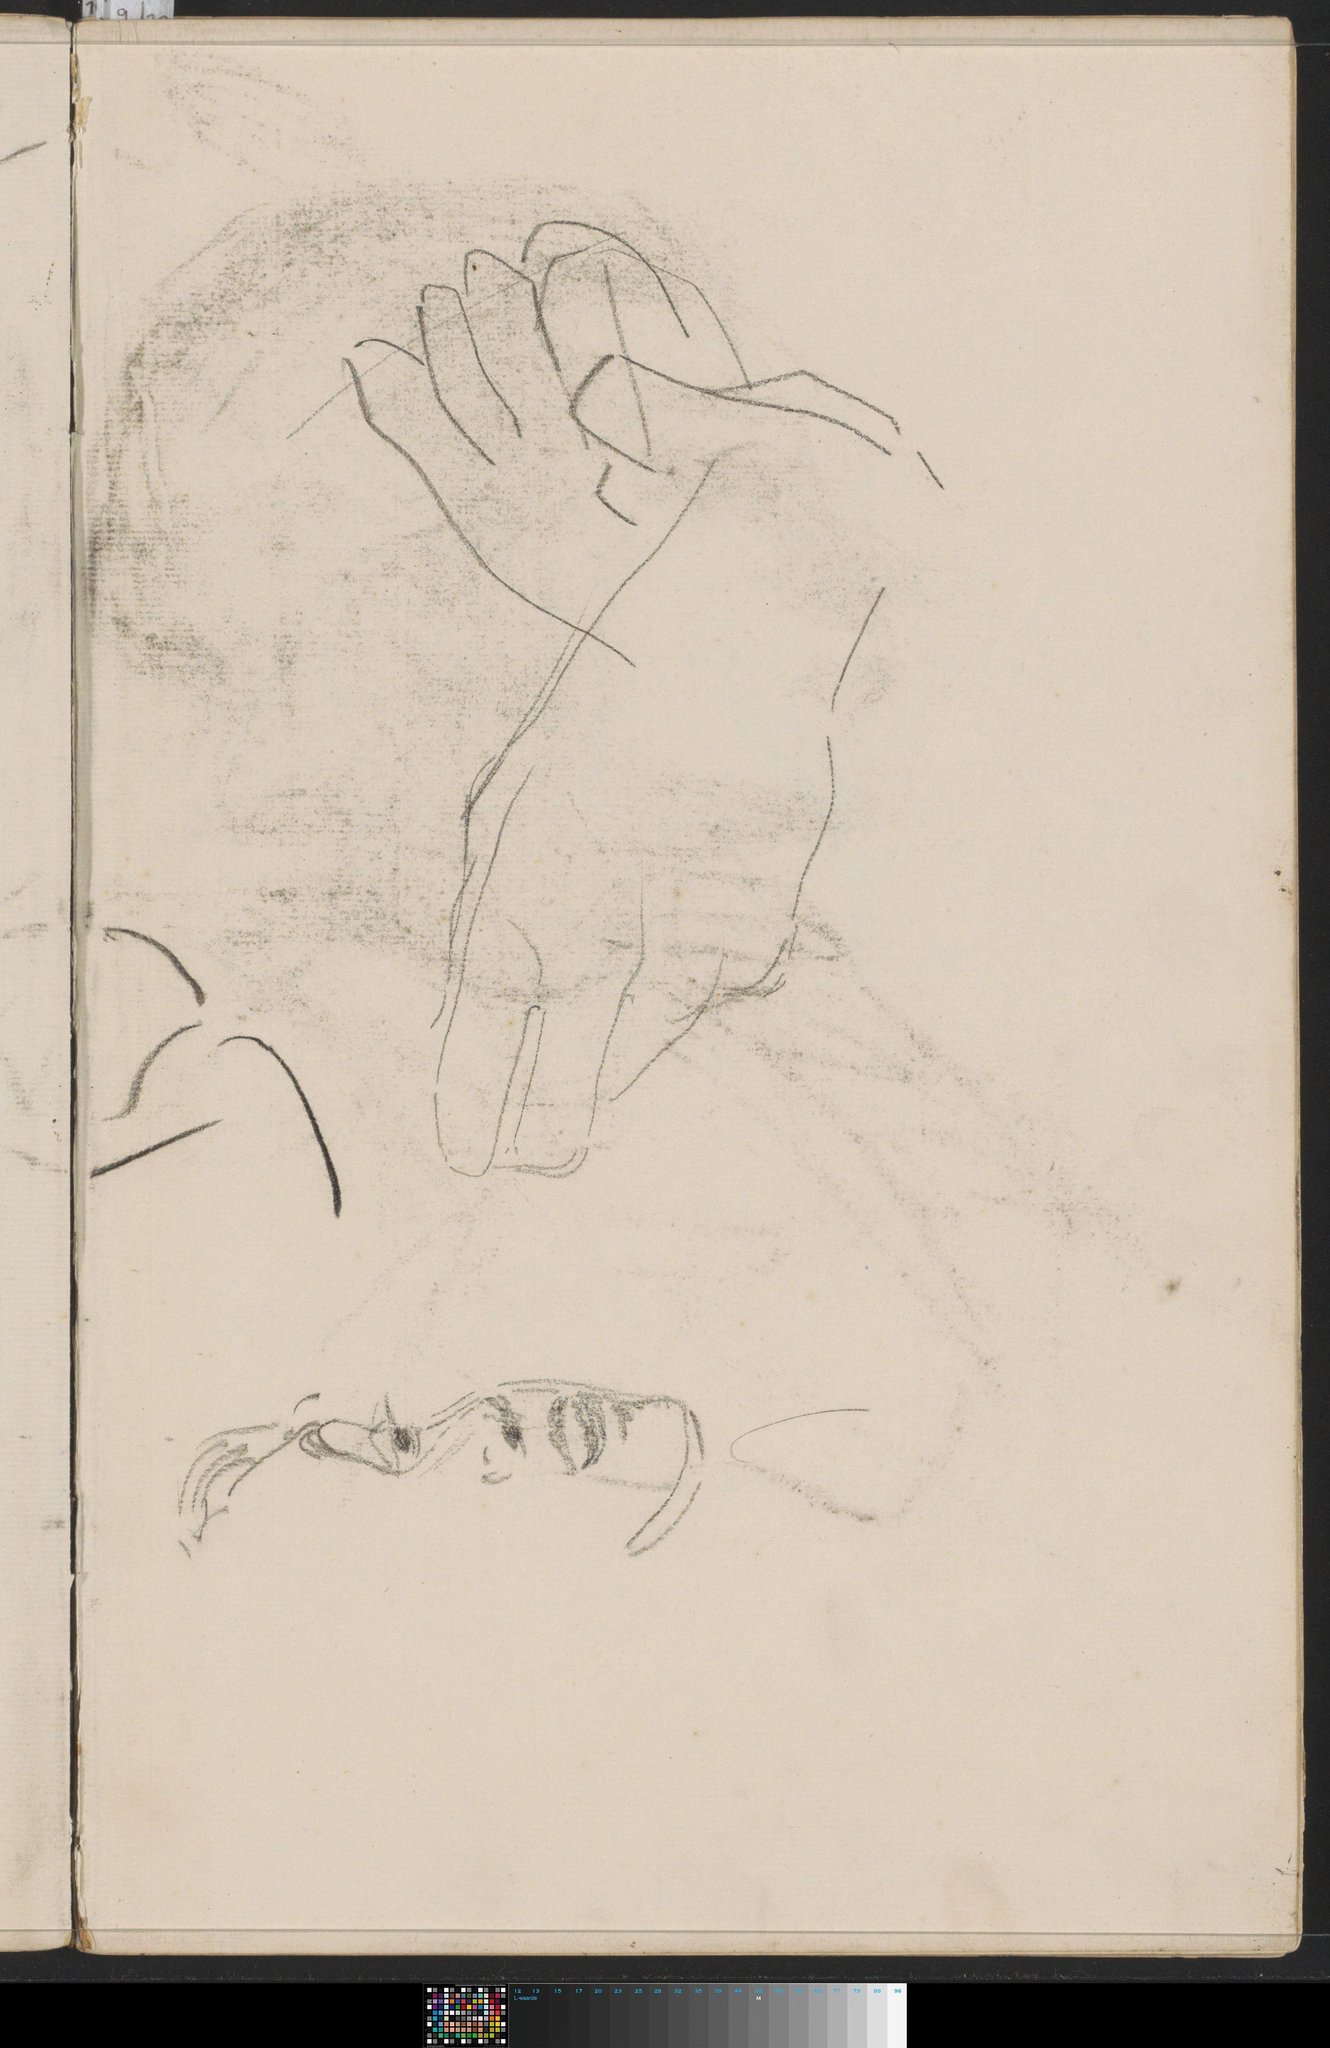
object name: sketchbook leaf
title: Handen en een gezicht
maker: carel adolph lion cachet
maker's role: draughtsman, print maker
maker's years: 1864-1945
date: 1897-1898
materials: chalk, paper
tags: face, hand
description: Blad 7 recto uit een schetsboek met 29 bladen.